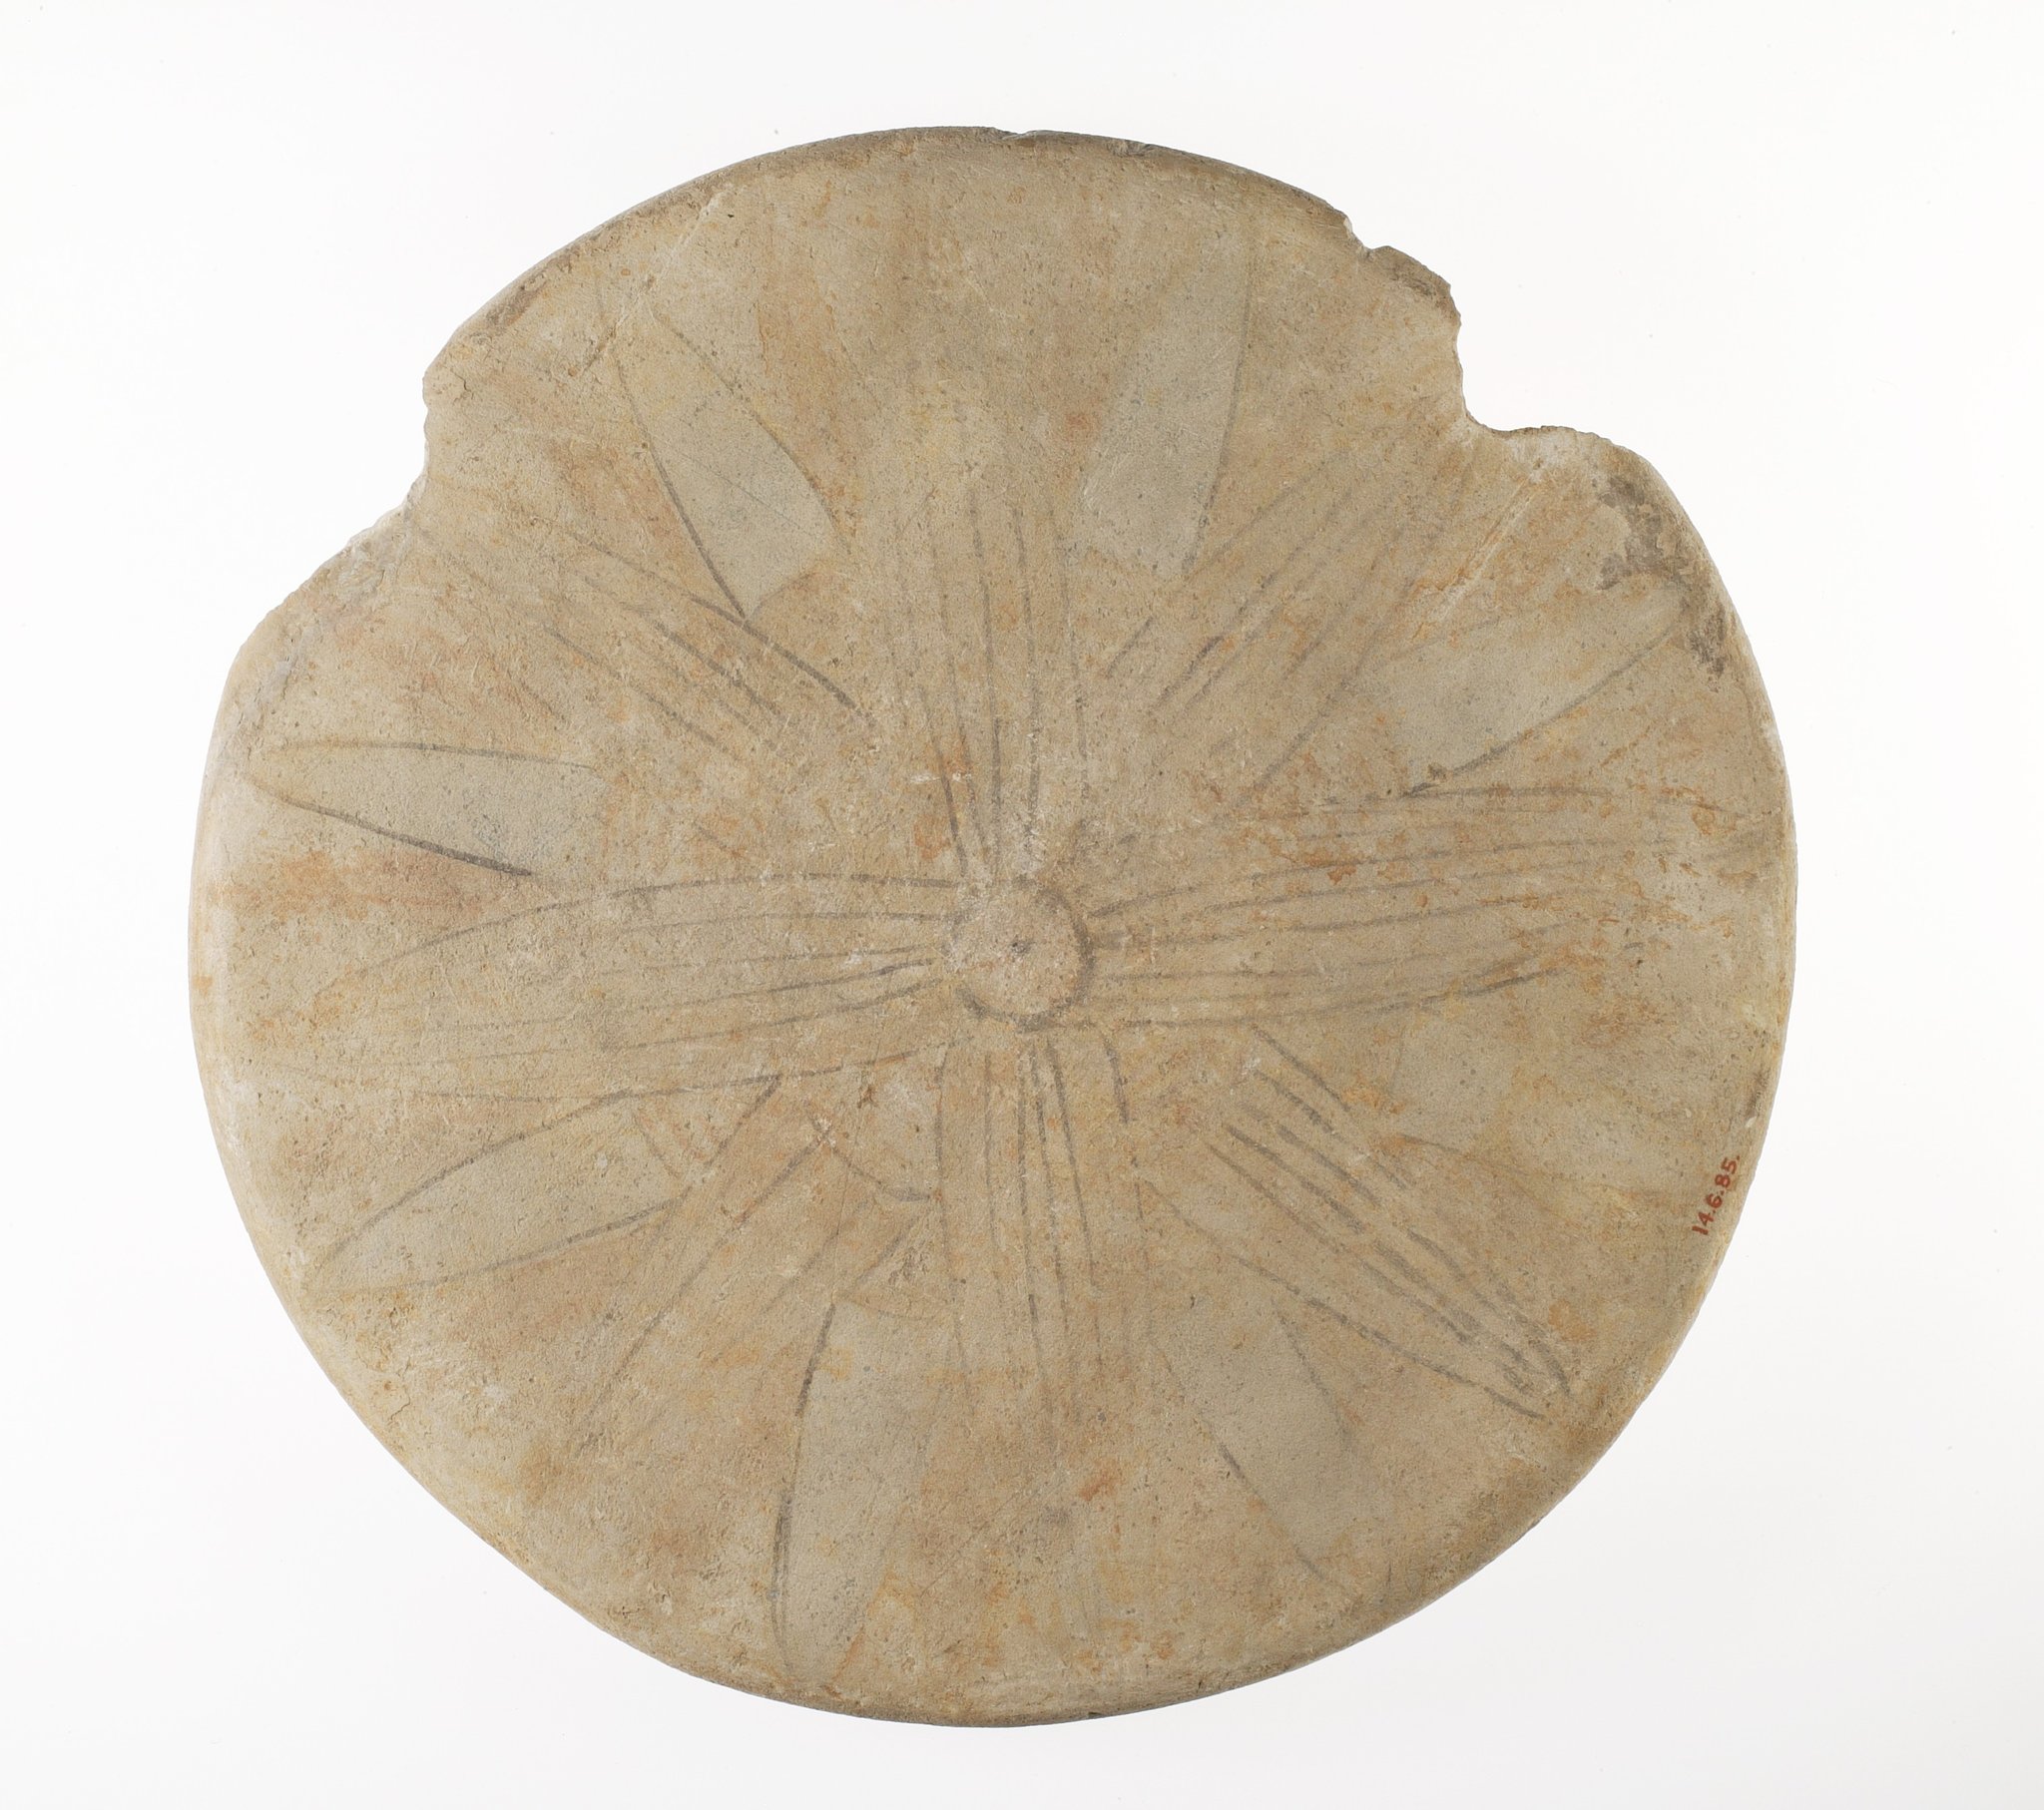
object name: jar lid, siptah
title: Disk-shaped Jar Lid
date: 1194-1188 BCE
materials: limestone, paint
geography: egypt